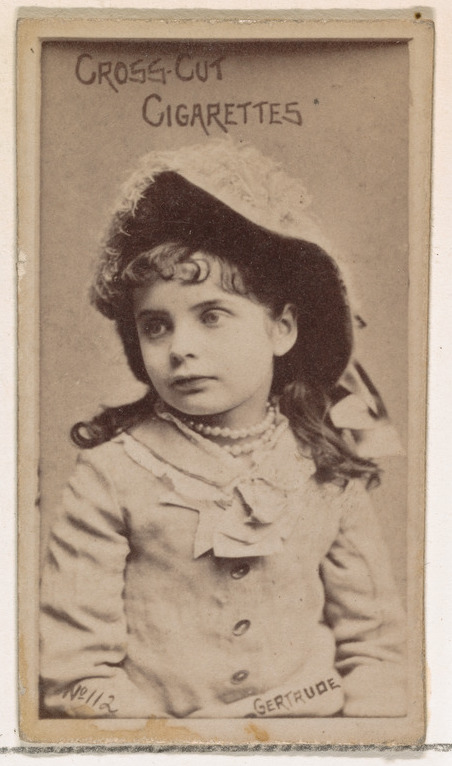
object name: print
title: Card Number 112, Gertrude, from the Actors and Actresses series (N145-1) issued by Duke Sons & Co. to promote Cross Cut Cigarettes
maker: w. duke, sons & co.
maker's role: publisher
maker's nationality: american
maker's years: 1870-1920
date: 1880-1889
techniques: albumen silver print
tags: girls,portraits,actors